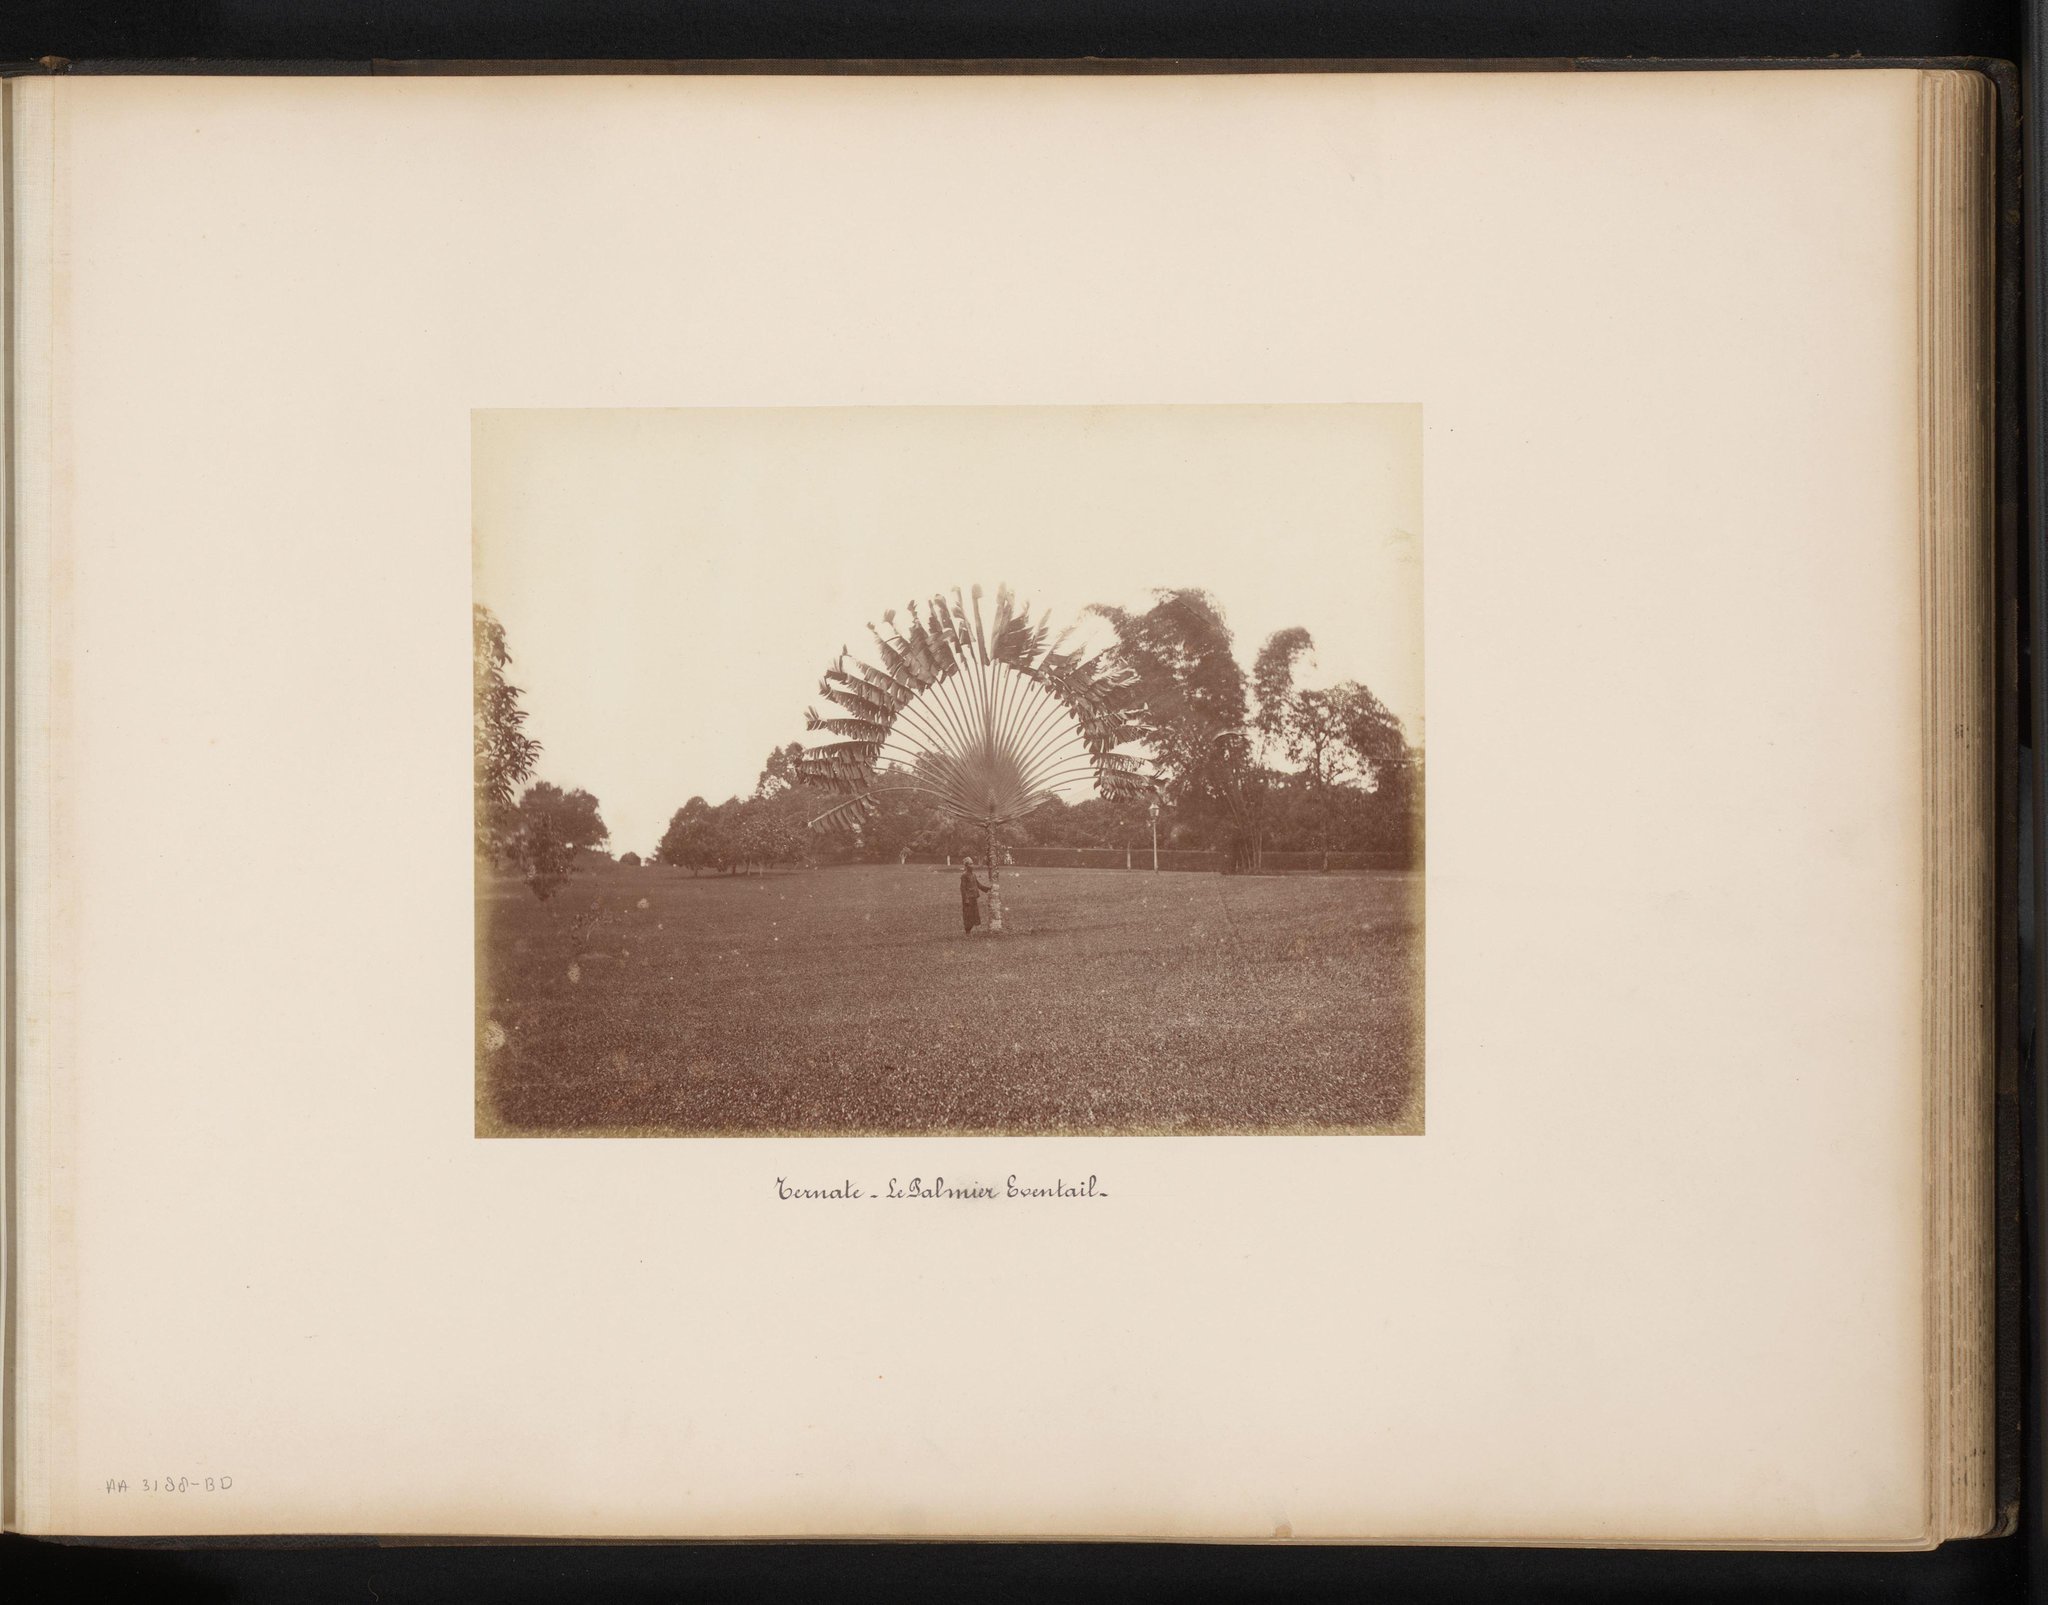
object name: photograph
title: Indische man poserend bij een waaierpalm op Ternate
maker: Anonymous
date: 1880-1883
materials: photographic support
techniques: albumen print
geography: ternate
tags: trees: palm-tree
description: Onderdeel van Reisalbum met opnames van bezienswaardigheden in Egypte, Nederlands-Indië, Singapore en Ceylon.